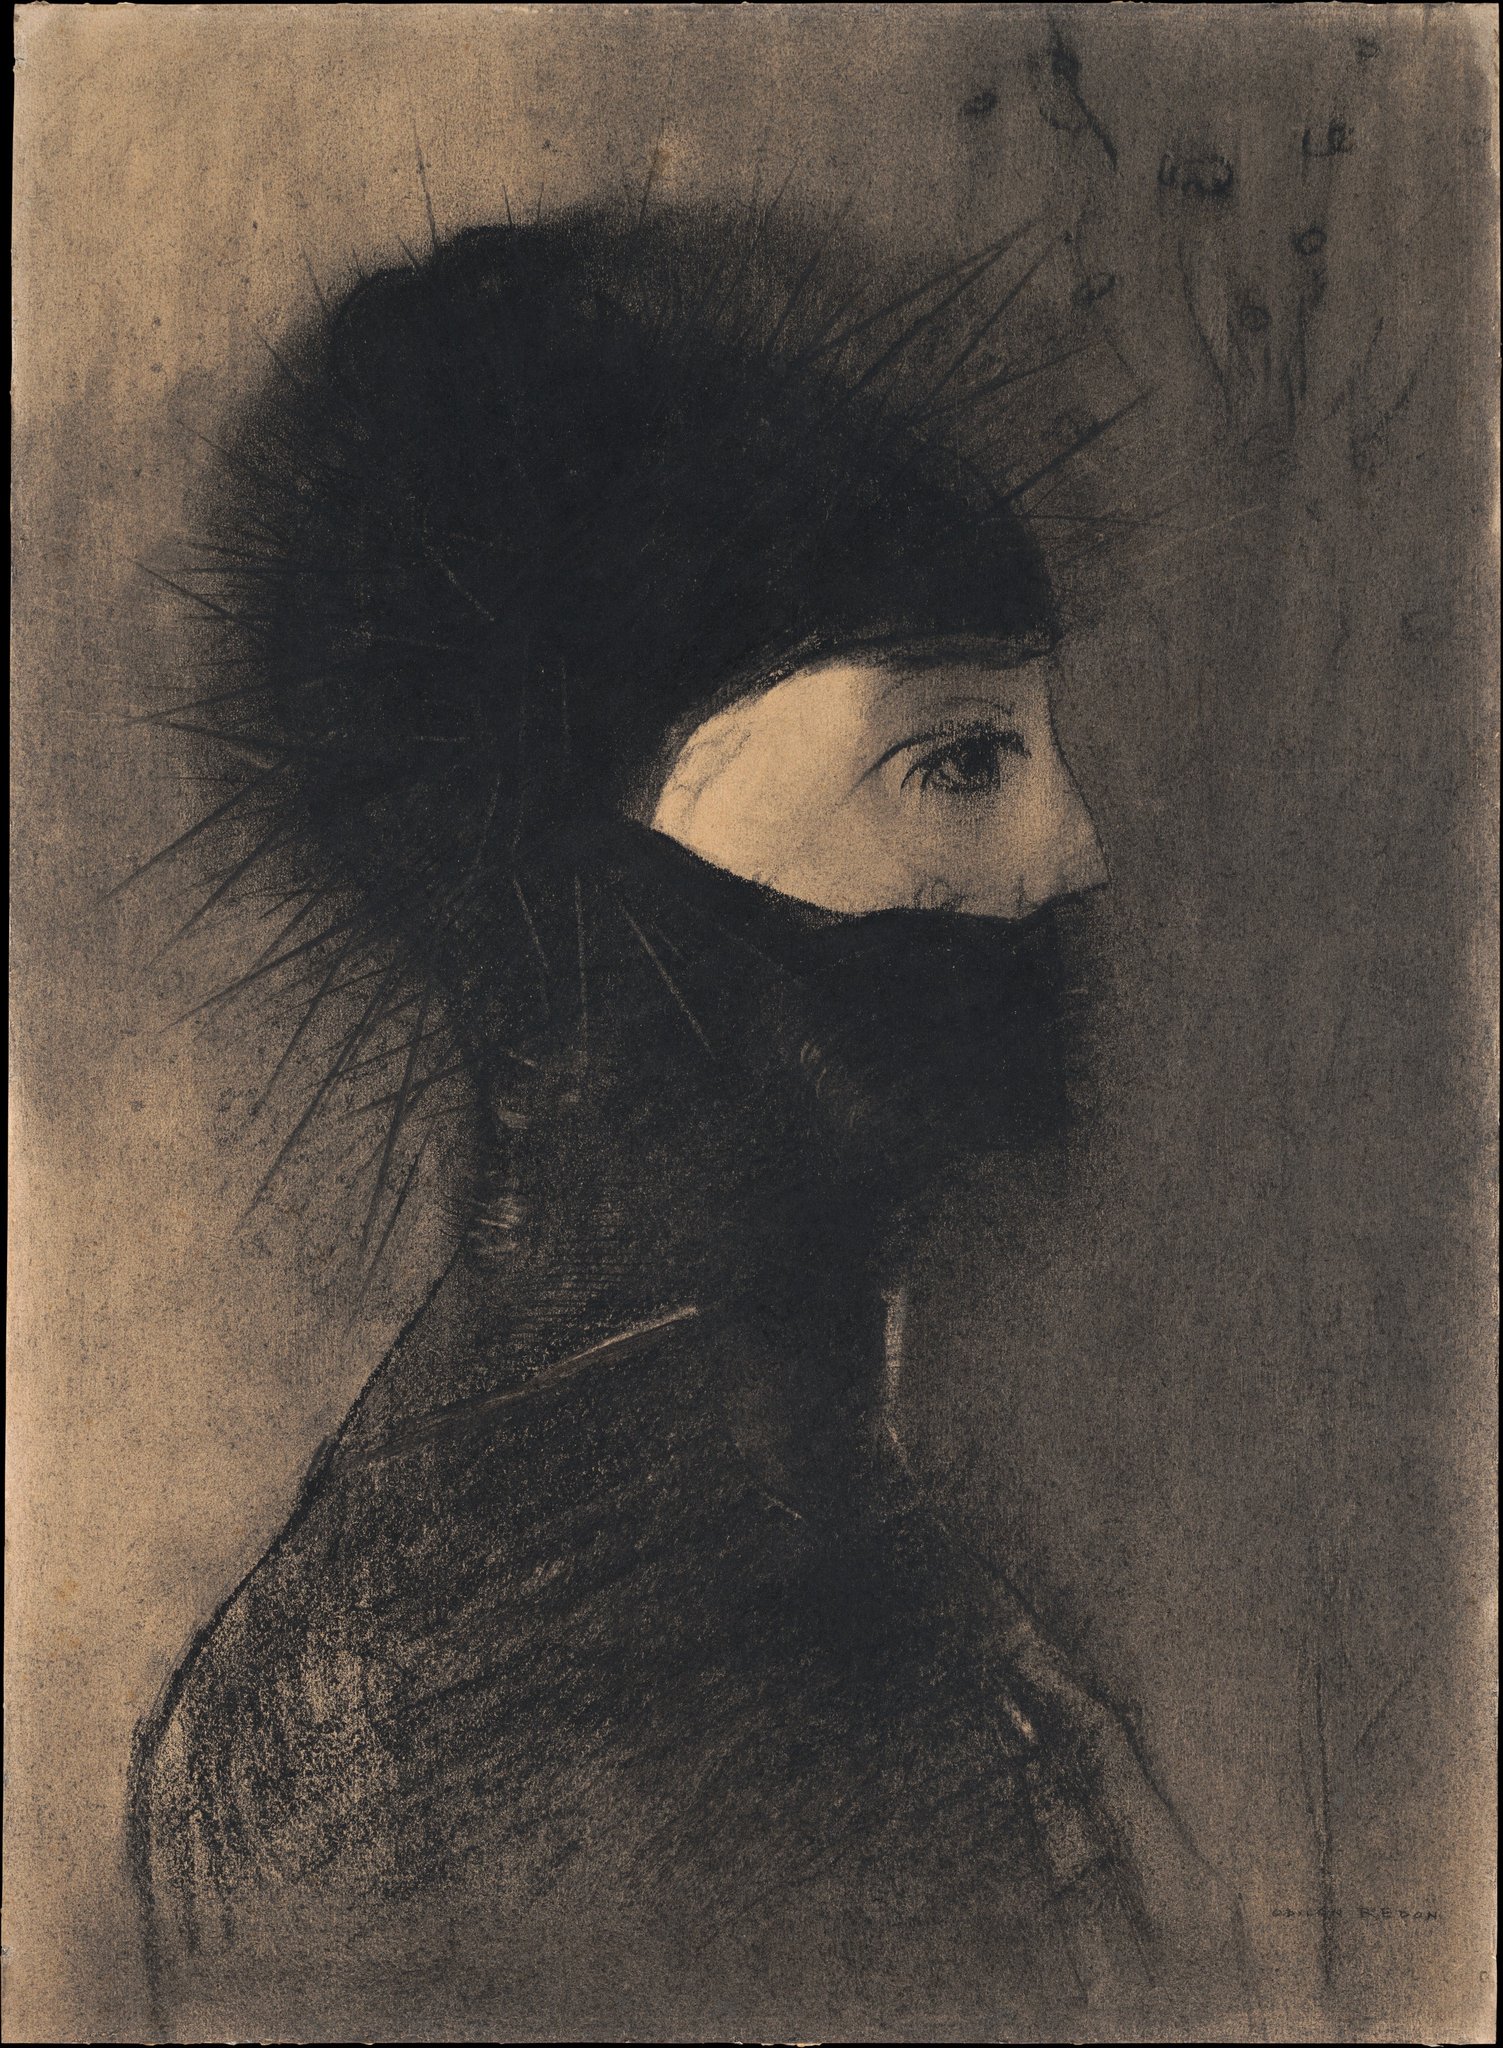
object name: drawing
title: Armor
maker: odilon redon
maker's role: artist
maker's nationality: french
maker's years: 1840-1916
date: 1891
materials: charcoal, crayon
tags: armor,helmets,women